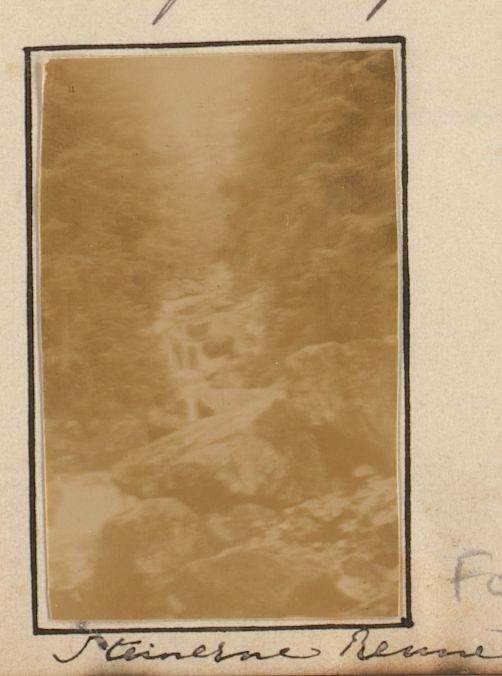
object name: album leaf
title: Gemeentehuis van Wernigerode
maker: Anonymous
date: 1885-1891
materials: photographic support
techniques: albumen print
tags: townhall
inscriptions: annotation: ‘Rathaus Wernigerode’, annotation: ‘[...] omtrent des [...]/ [...] Waldkaters nauwgezet/ (...)’